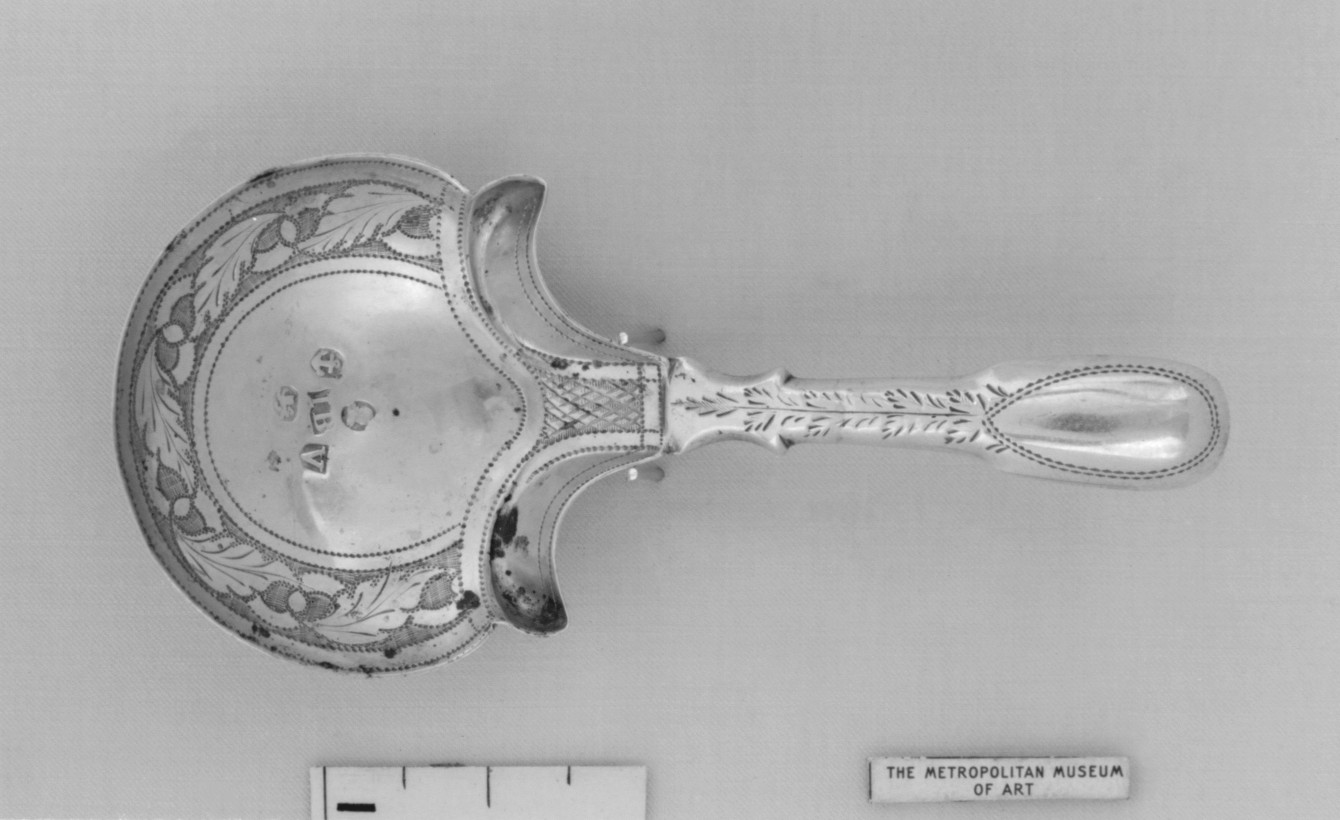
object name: tea caddy with spoon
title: Tea caddy spoon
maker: john bettridge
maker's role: maker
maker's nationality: british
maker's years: 1817-1835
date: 1819-1820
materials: silver